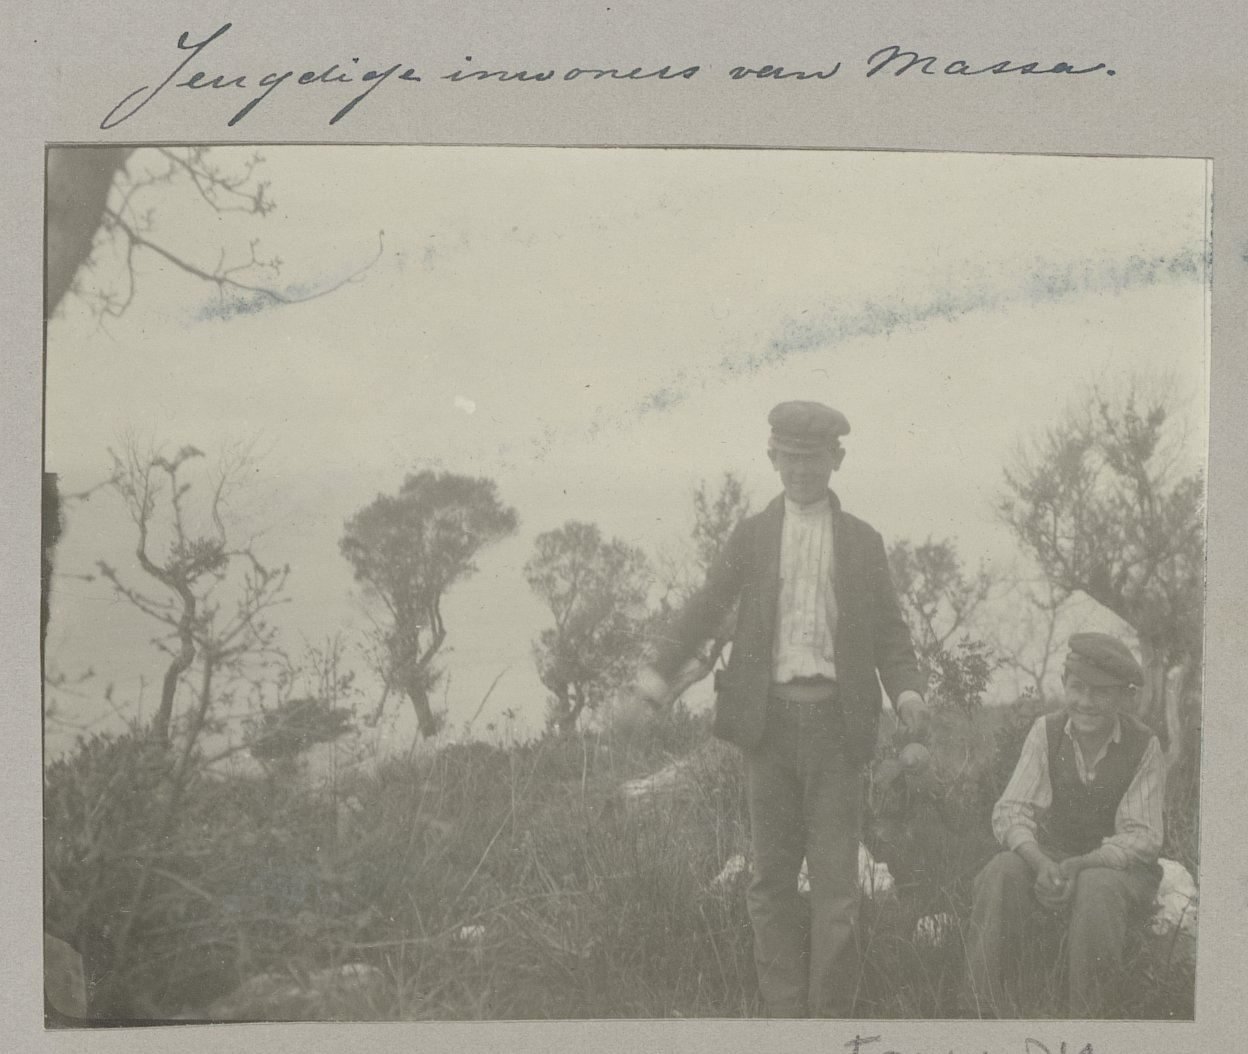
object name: photograph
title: Twee jongens uit Massa in een weiland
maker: Anonymous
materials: photographic support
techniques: gelatin silver print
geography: italy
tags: youth, adolescent, meadow, pasture (+ landscape with figures, staffage), italy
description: In Italië zijn meerdere plaatsen met de naam Massa. Onduidelijk is welke plaats hier afgebeeld is.